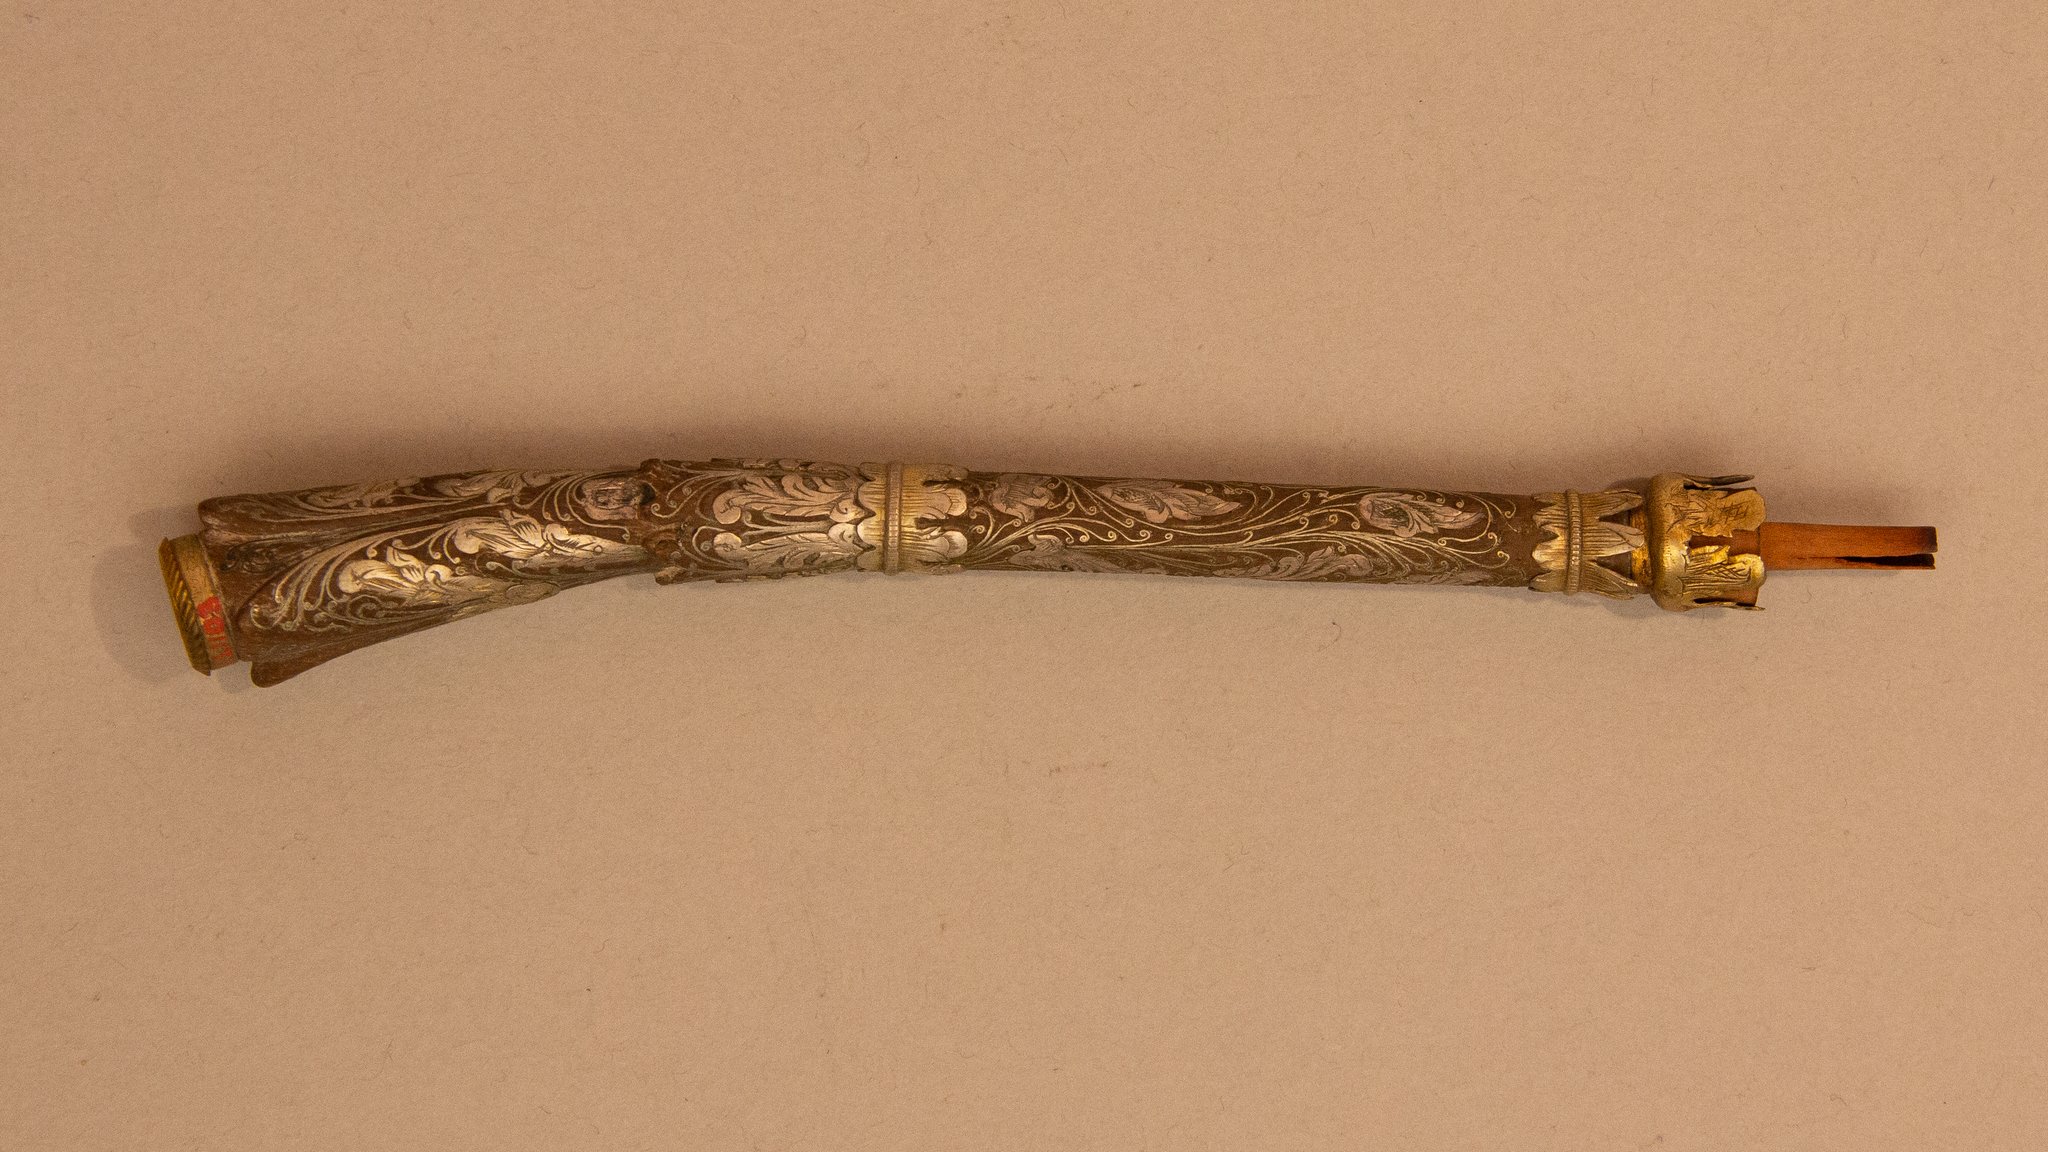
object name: fragment of a pipe stem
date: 1701-1900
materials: brass, silver, wood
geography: iran